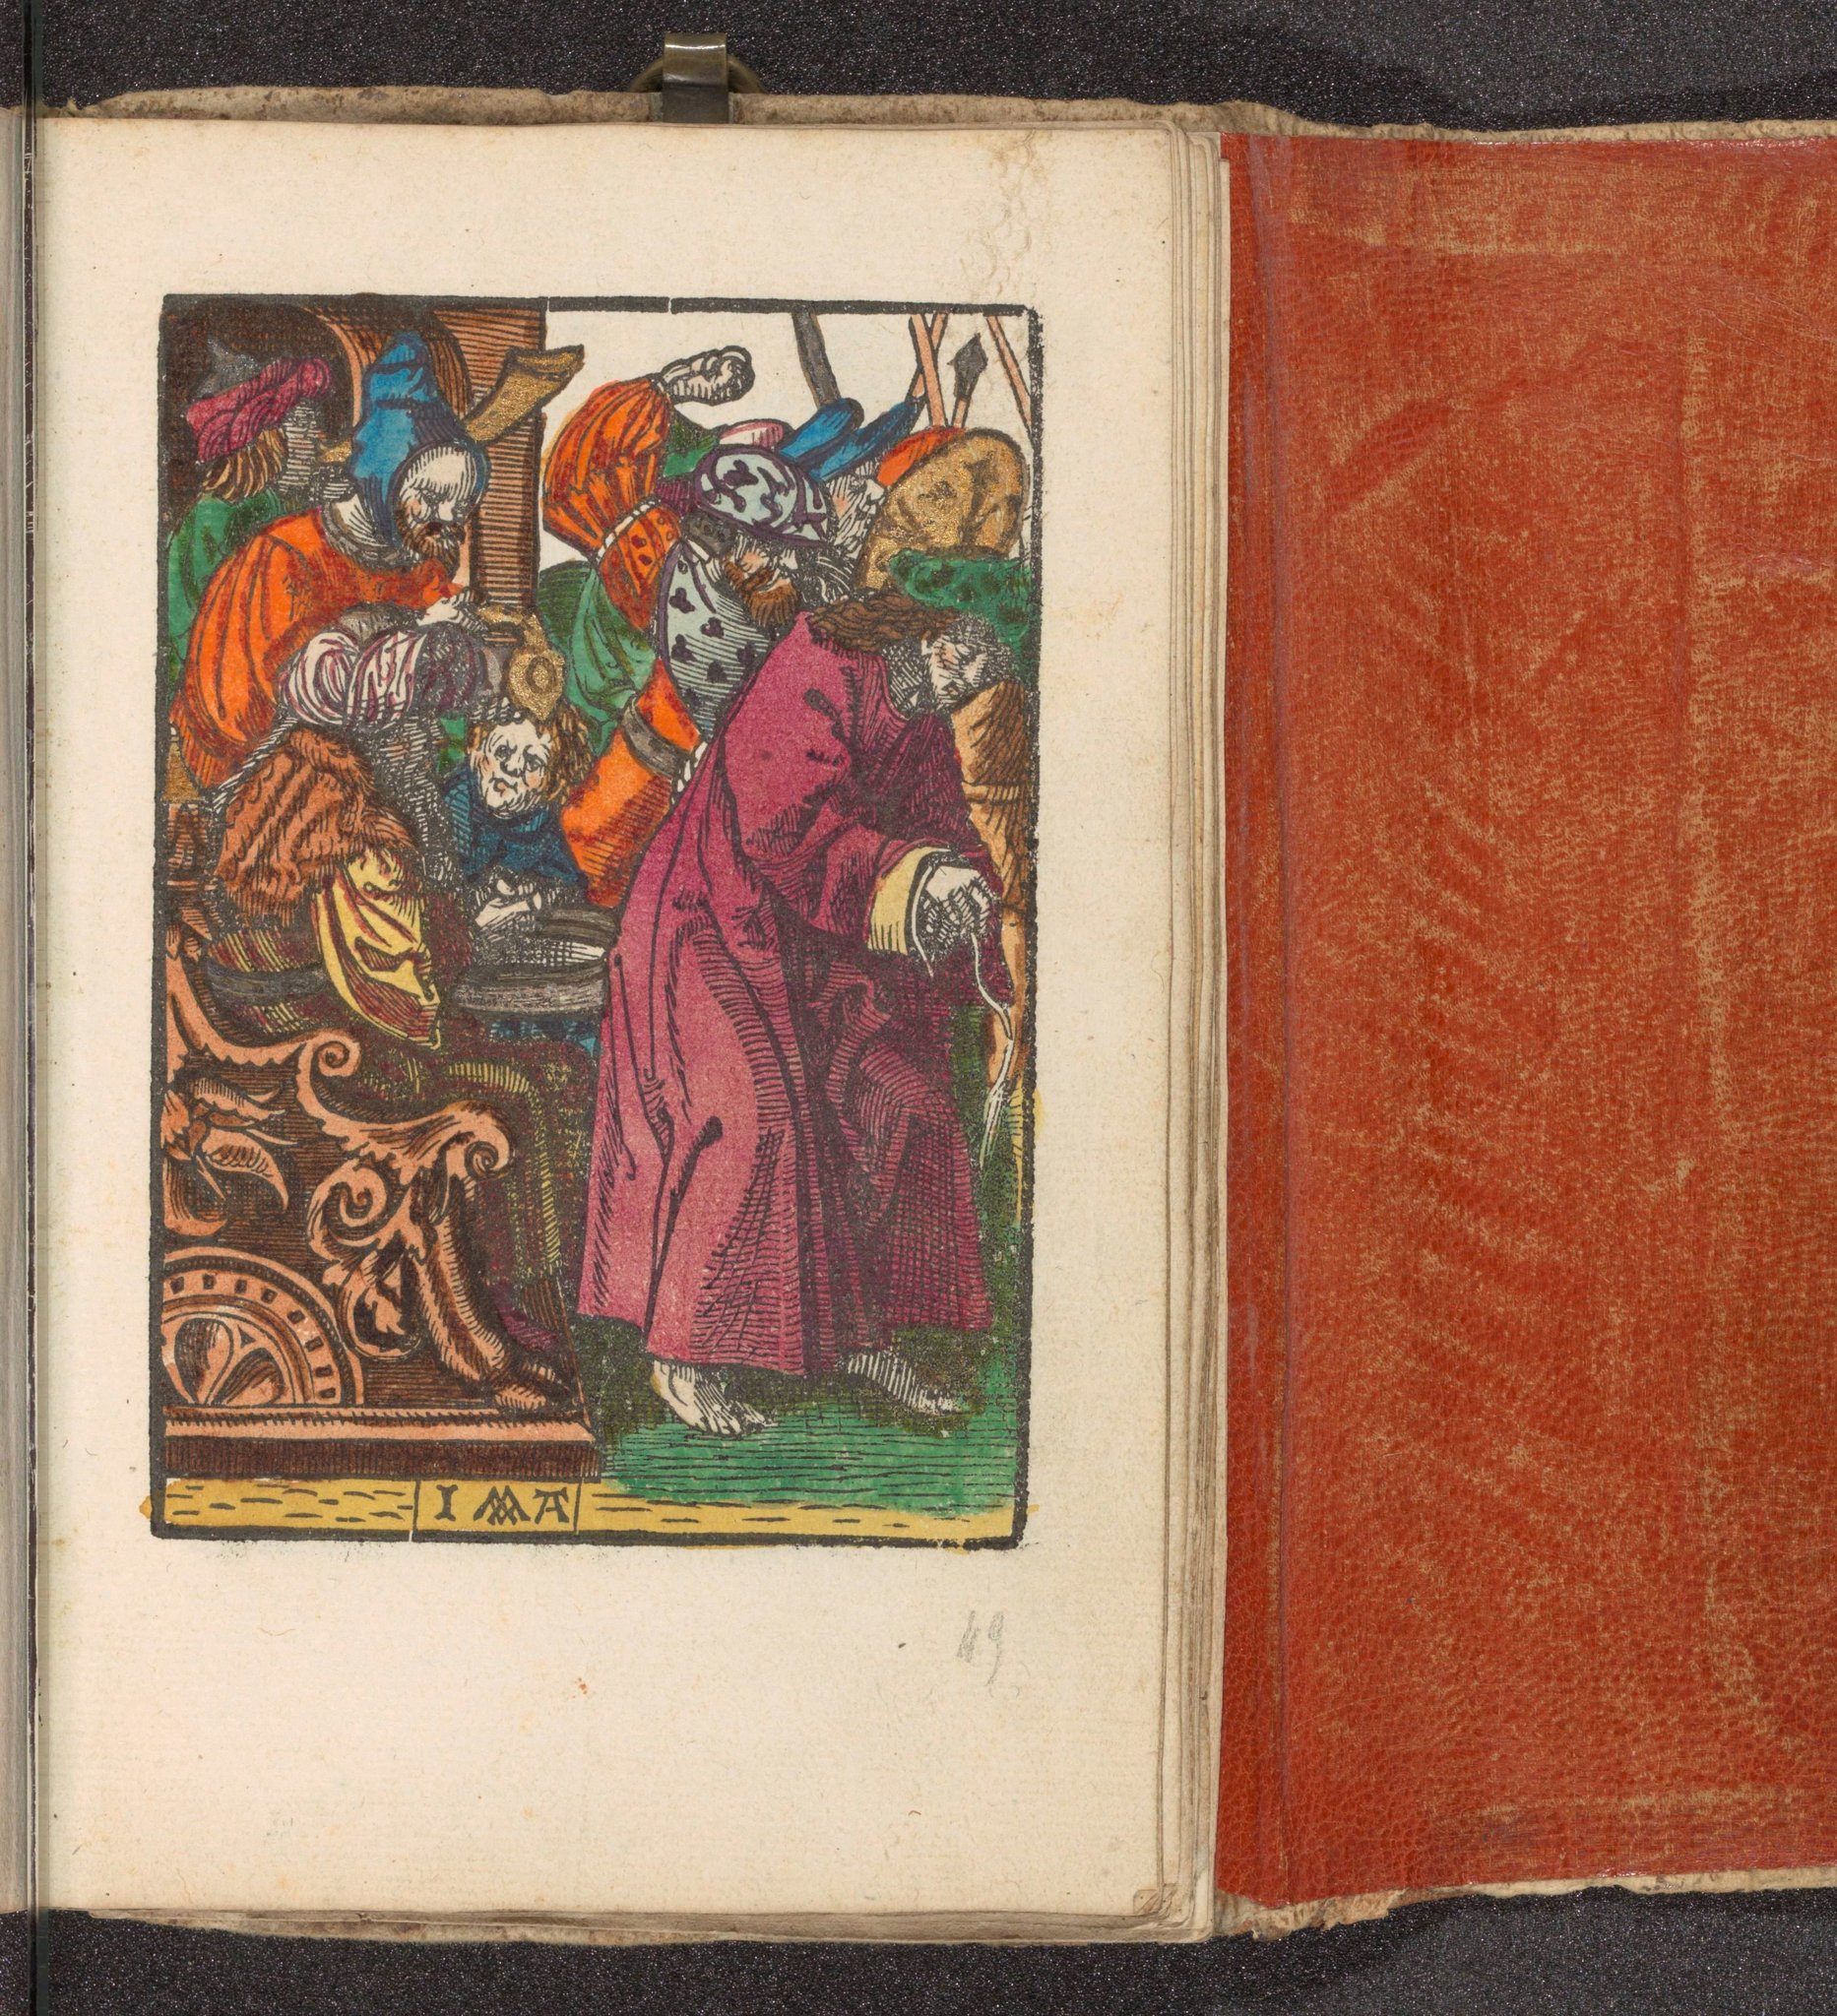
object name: album leaf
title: De kleine Passie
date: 1520-1521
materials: paper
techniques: hand coloring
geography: amsterdam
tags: book in which illustrations are essential, pilate washing his hands (in innocence)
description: Pilatus wast zijn handen in onschuld. Christus wordt weggeleid. Prent maakt deel uit van een boek.